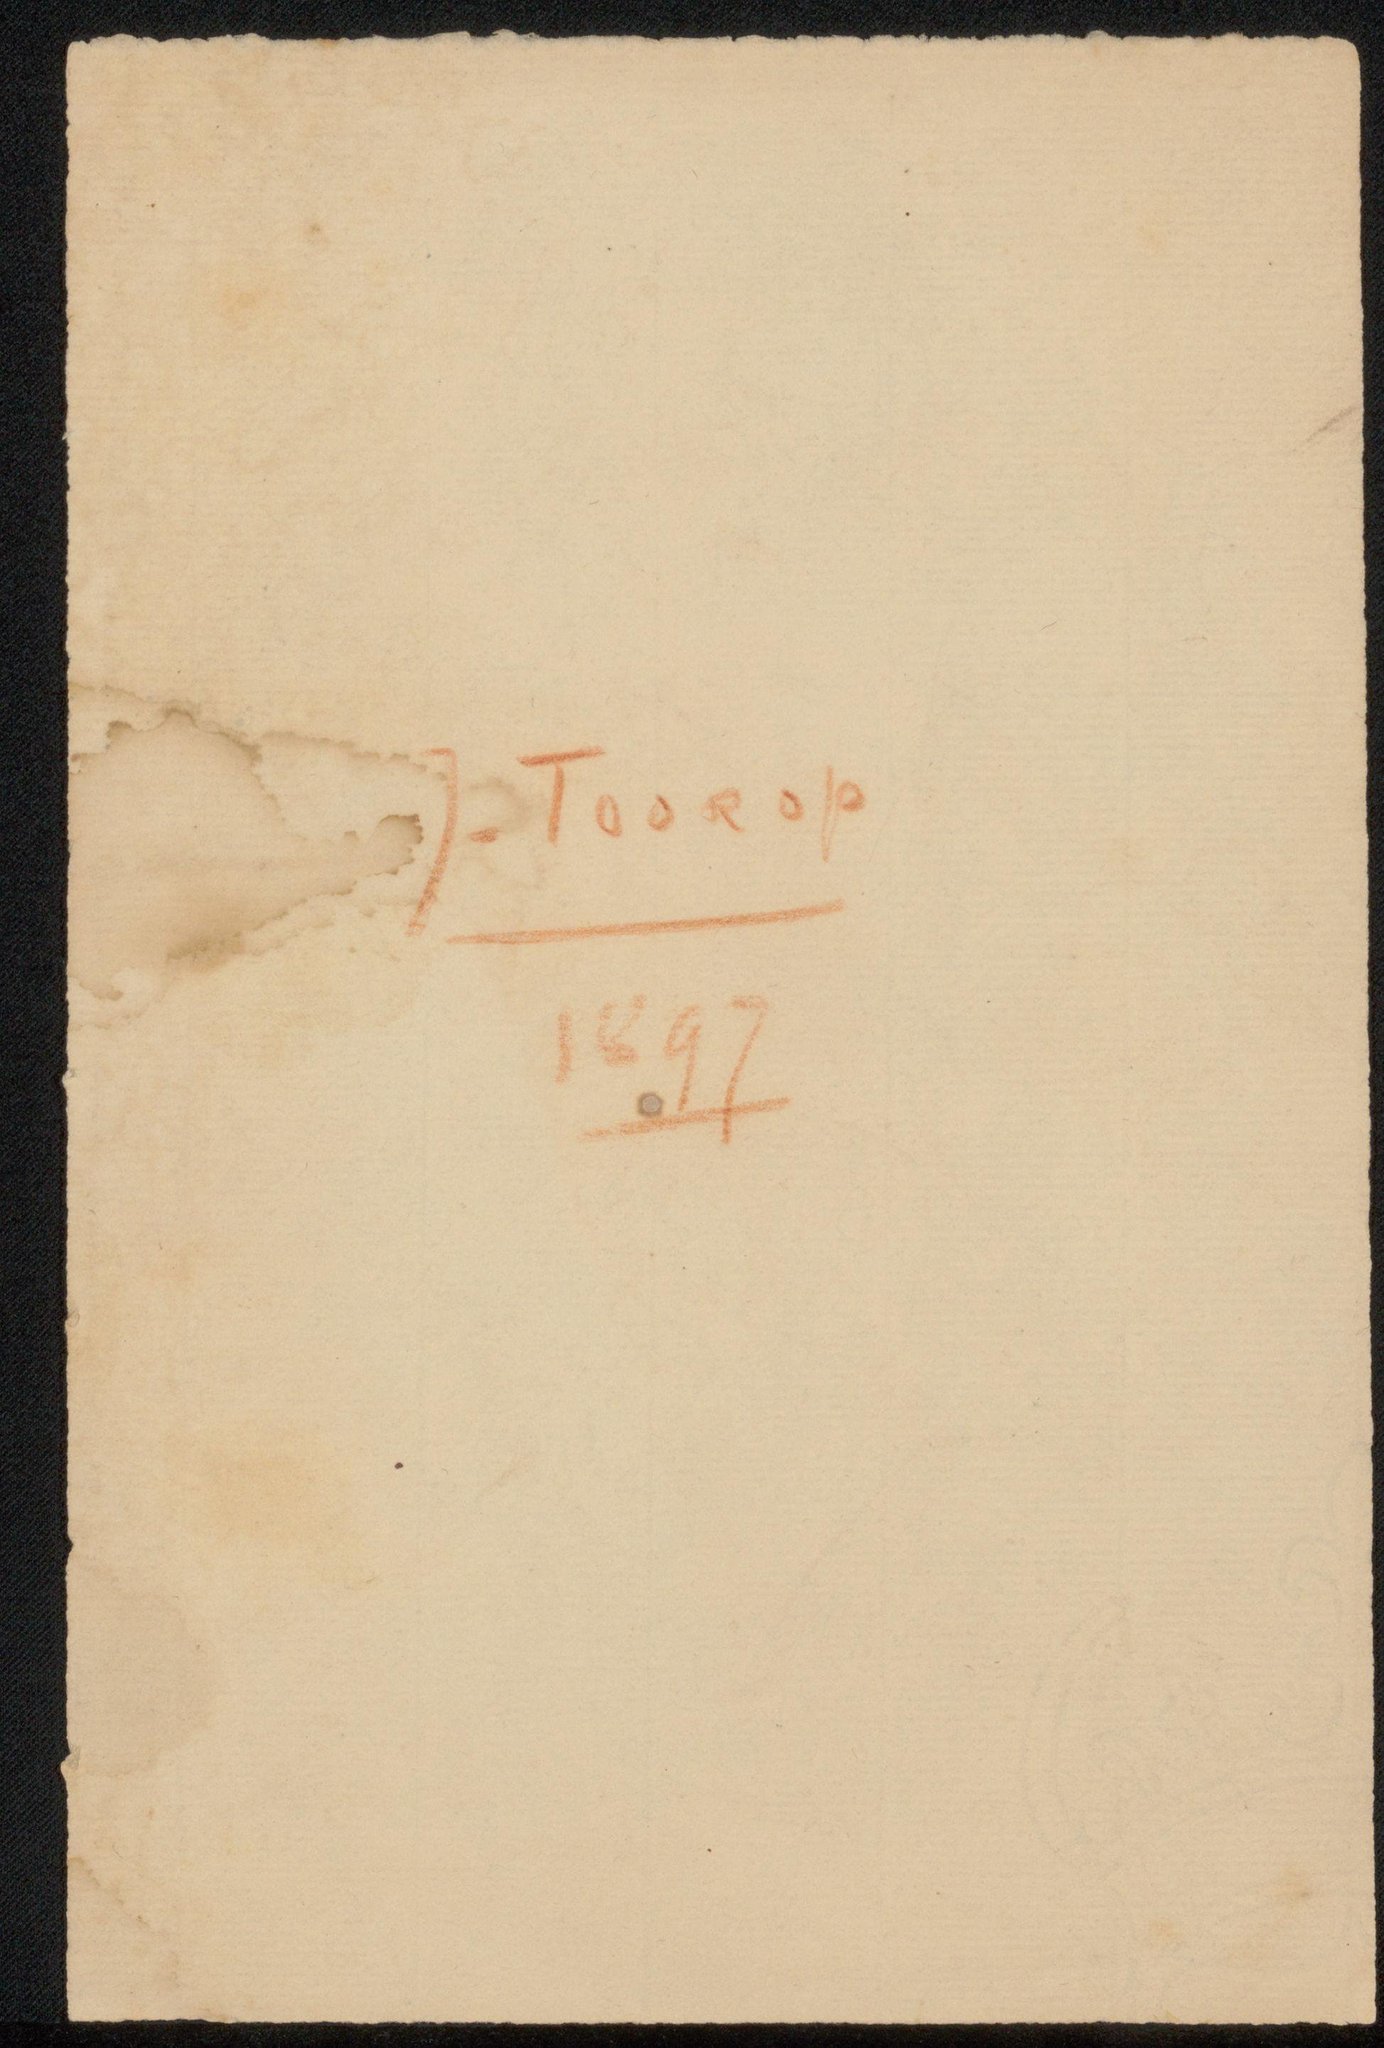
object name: aantekening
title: Aantekening uit archief Philip Zilcken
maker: Anonymous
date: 1897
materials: chalk, paper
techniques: writing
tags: the hague, painter, print maker, draughtsman, jan toorop, philip zilcken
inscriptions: watermark, collector's mark: ‘RPK’